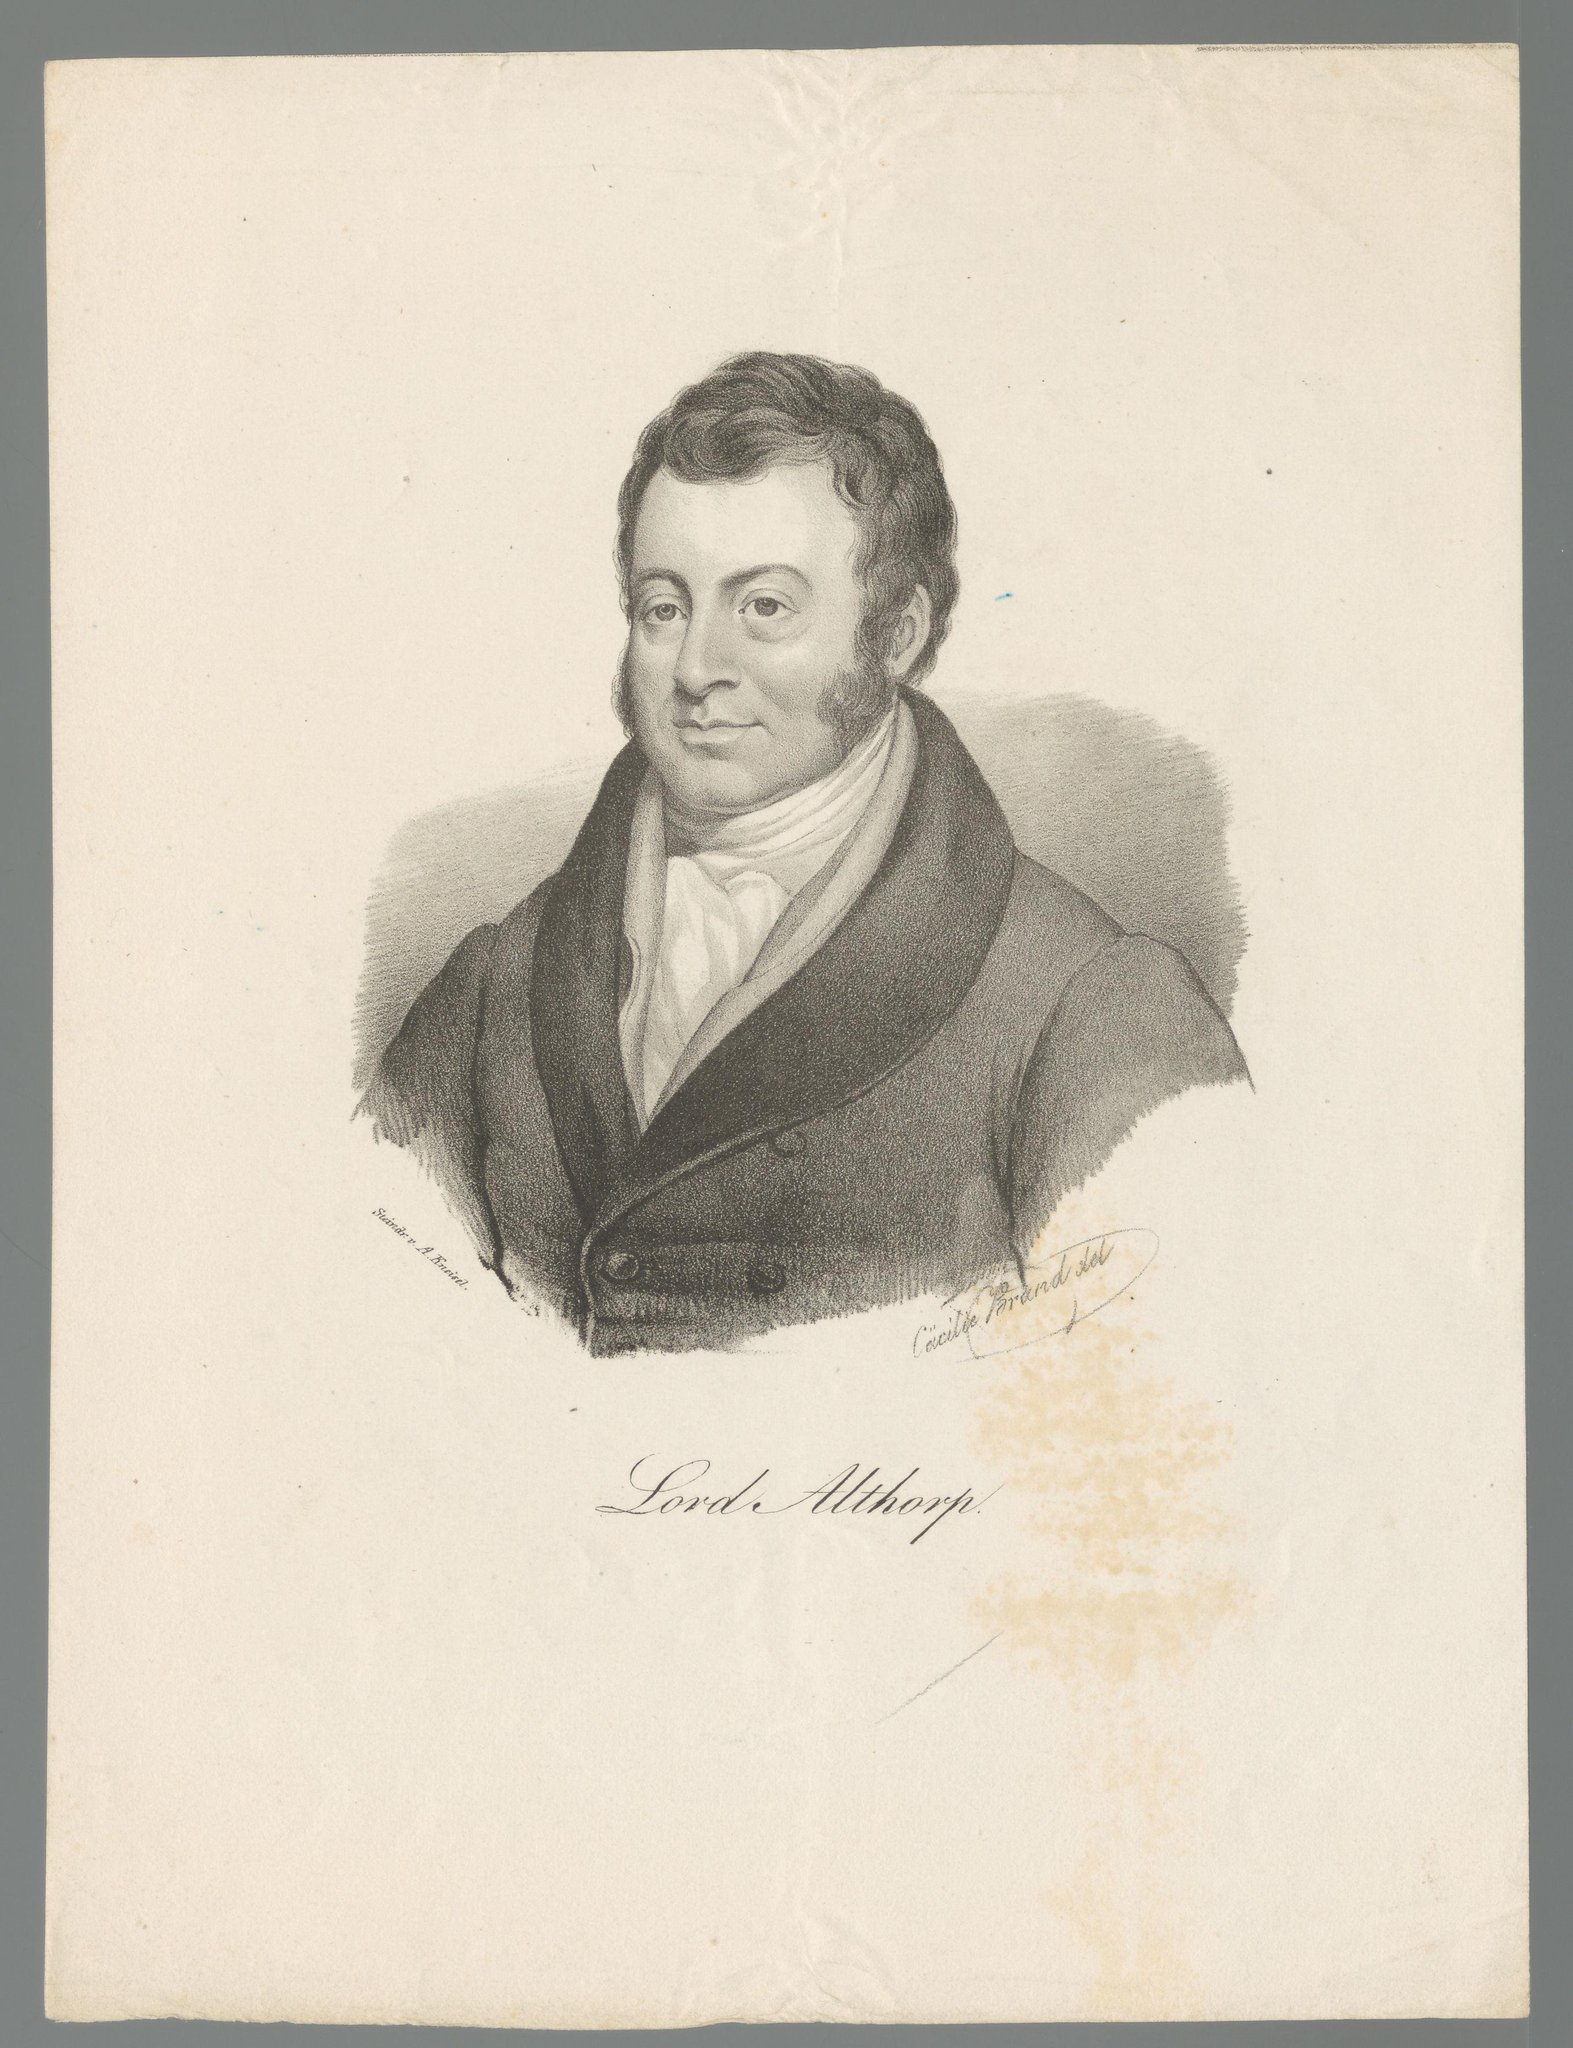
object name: print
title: Portret van John Charles Spencer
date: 1834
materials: paper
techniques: lithograph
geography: leipzig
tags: adult man, historical persons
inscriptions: collector's mark: Lugt 2228